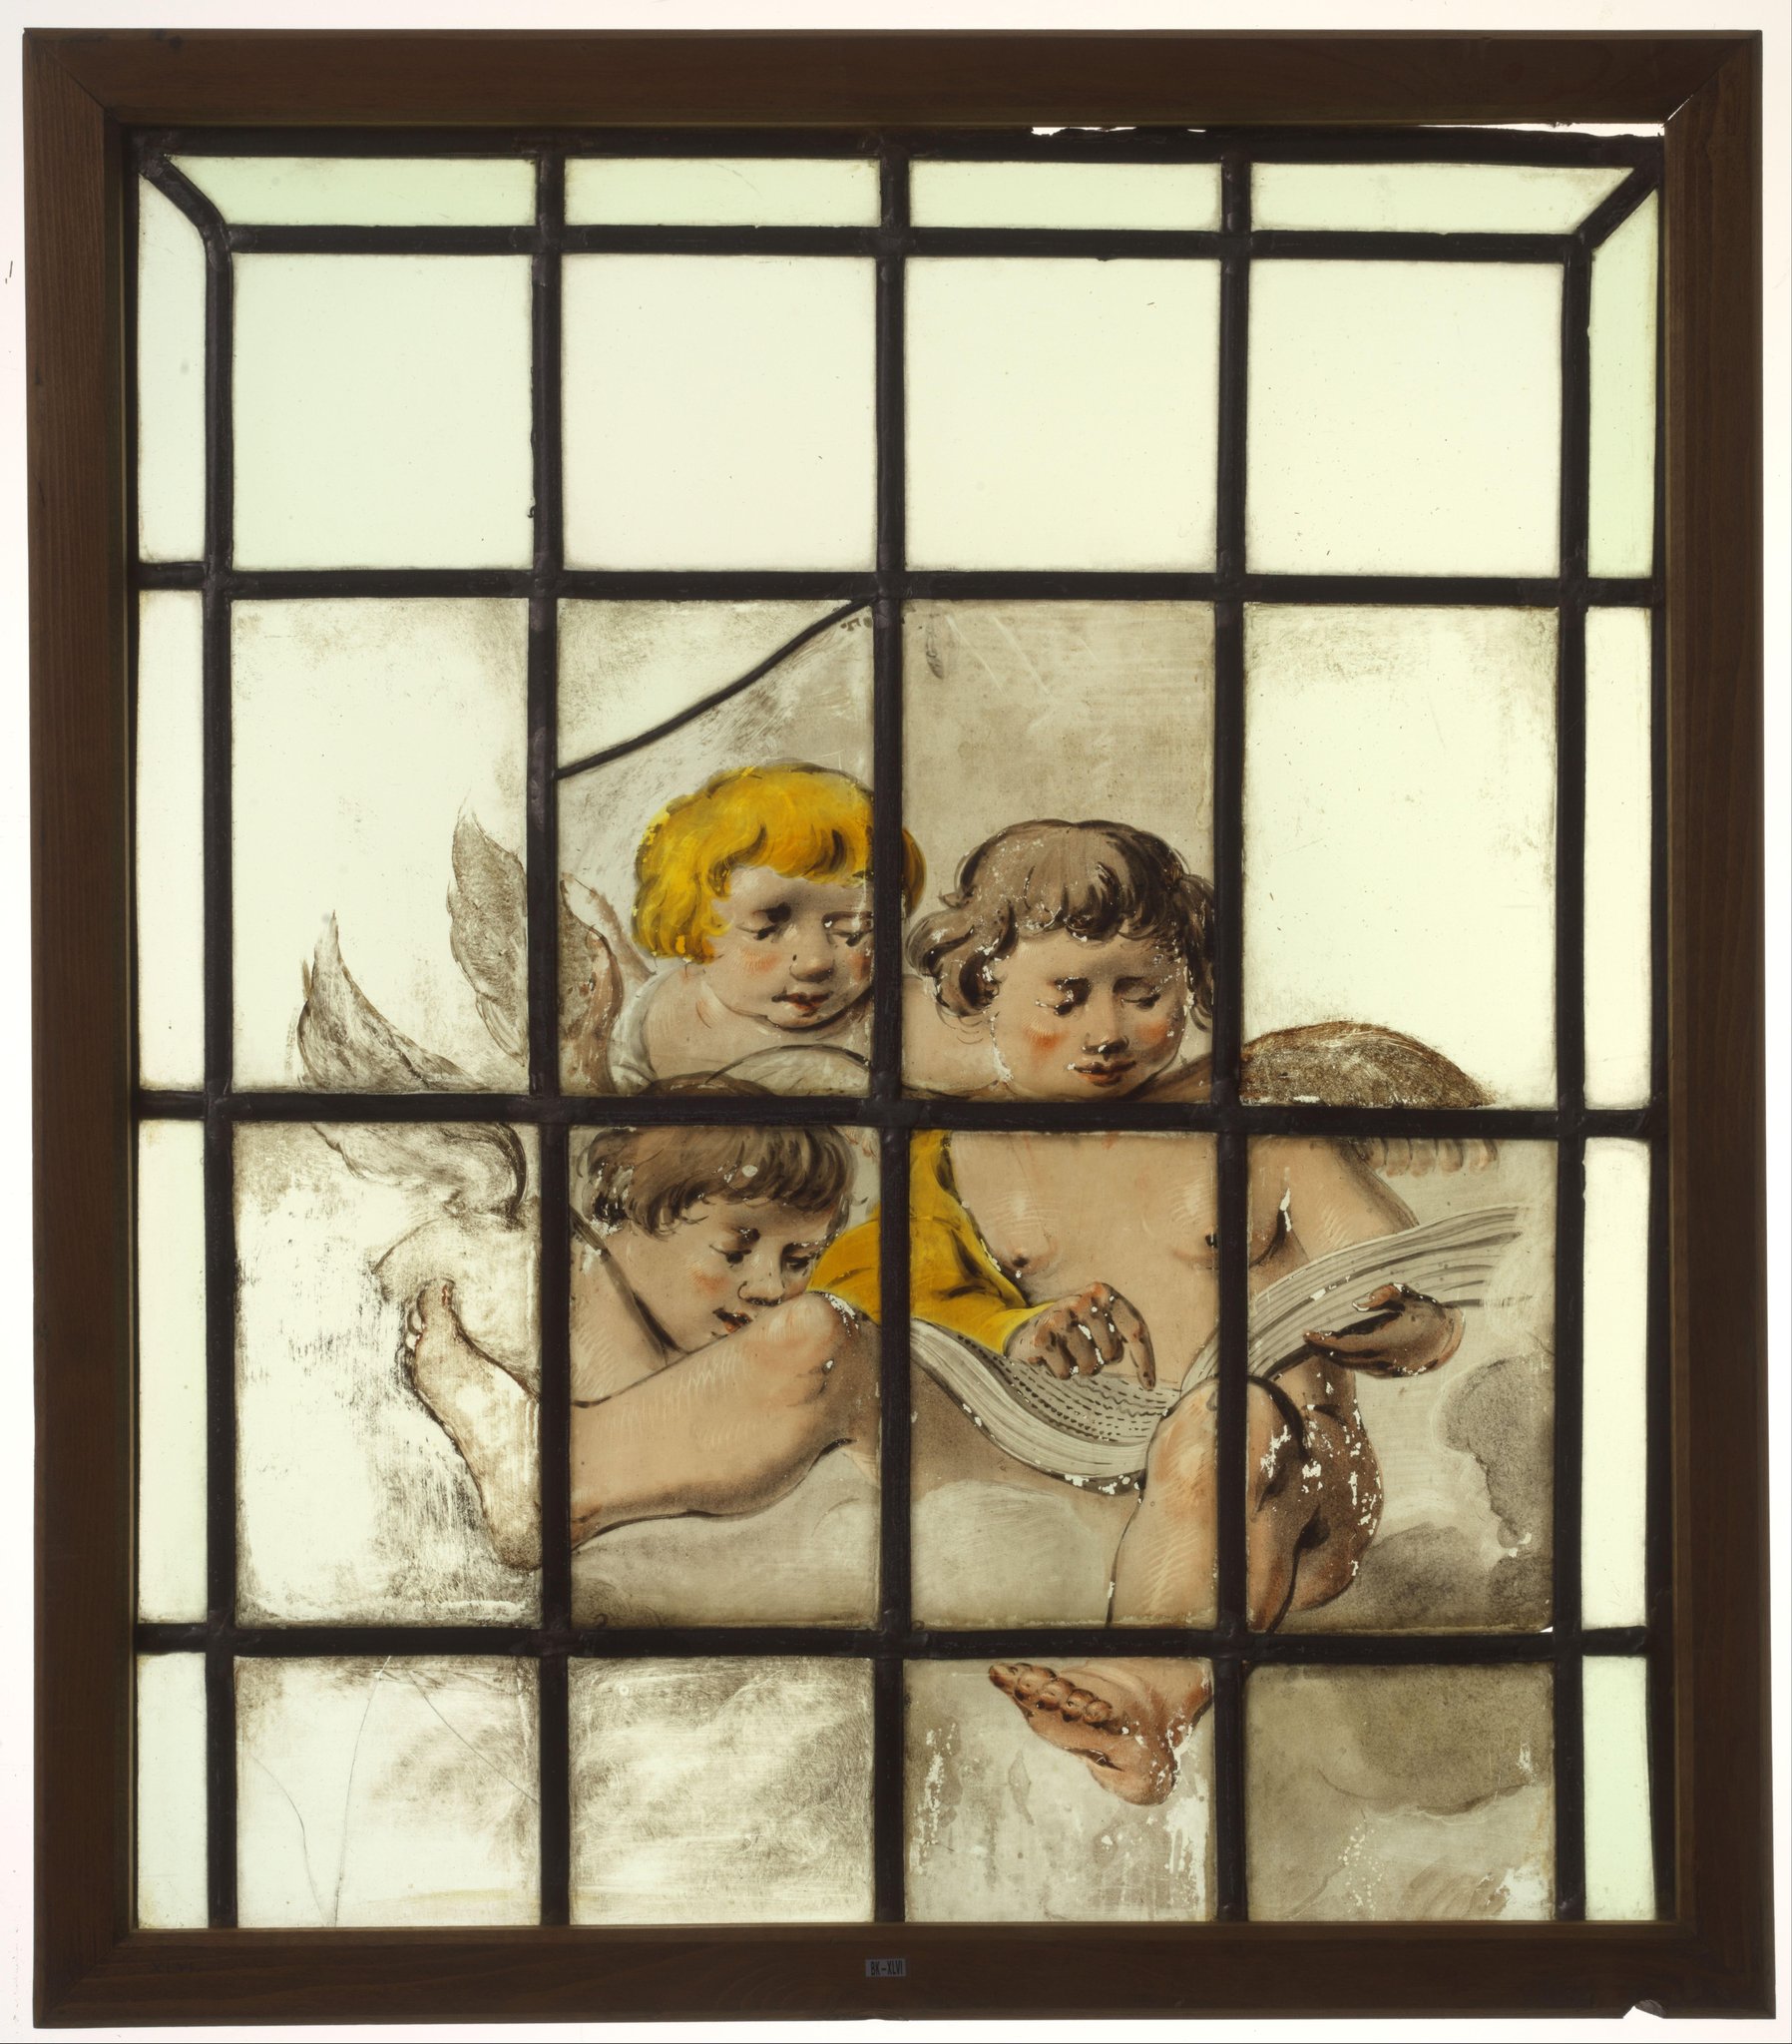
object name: light window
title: Ruit met drie engelen waarvan één met boek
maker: Anonymous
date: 1600-1699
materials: glass, lead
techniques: leading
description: Ruit met de voorstelling van drie engeltjes in de wolken. Eén der engelen heeft een boek op schoot.